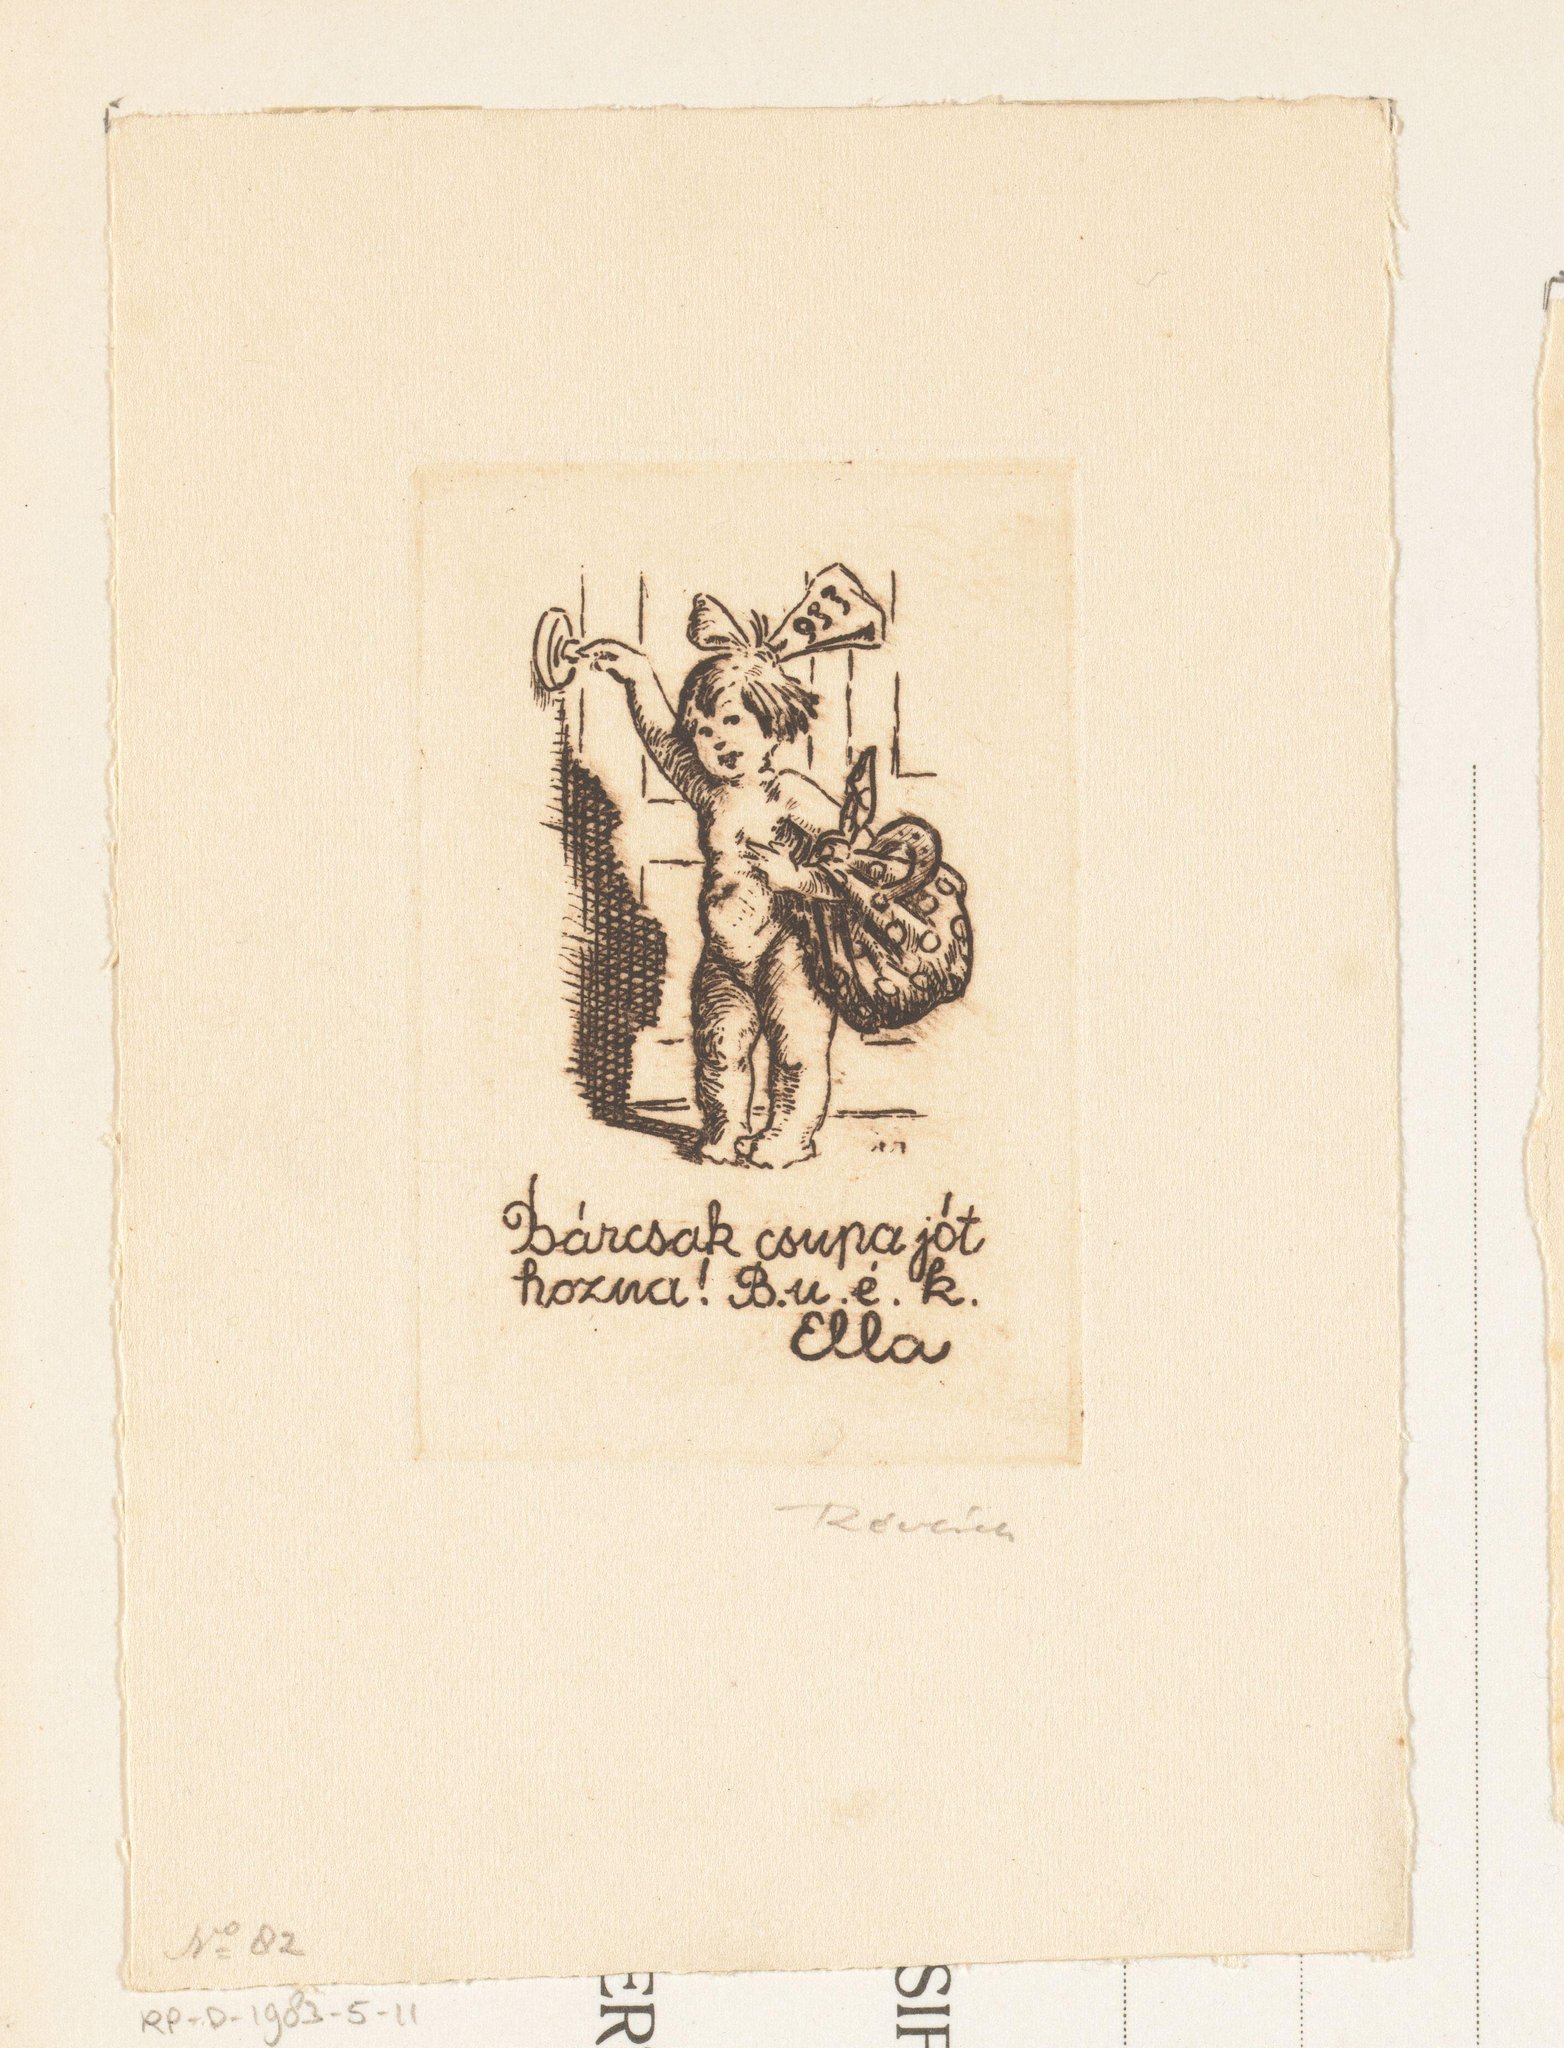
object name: new year card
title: Bárcsak csupa jót hozna! B.u.é.k.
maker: kornél révész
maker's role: print maker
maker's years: 1885-1944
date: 1932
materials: paper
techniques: etching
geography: budapest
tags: toddler (female), horseshoe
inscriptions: inscription: ‘"Möge es [...] gutes/ bringen"’, workshop stamp: ‘Fecit/ Révész Kornél/ Budapest’, signature: ‘Révész’, date: ‘Nr. 82/ 1932’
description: Ex libris maakt deel uit van omslag met 64 ex libris op 34 losse opzetvellen, een catalogus en een tekstblad.